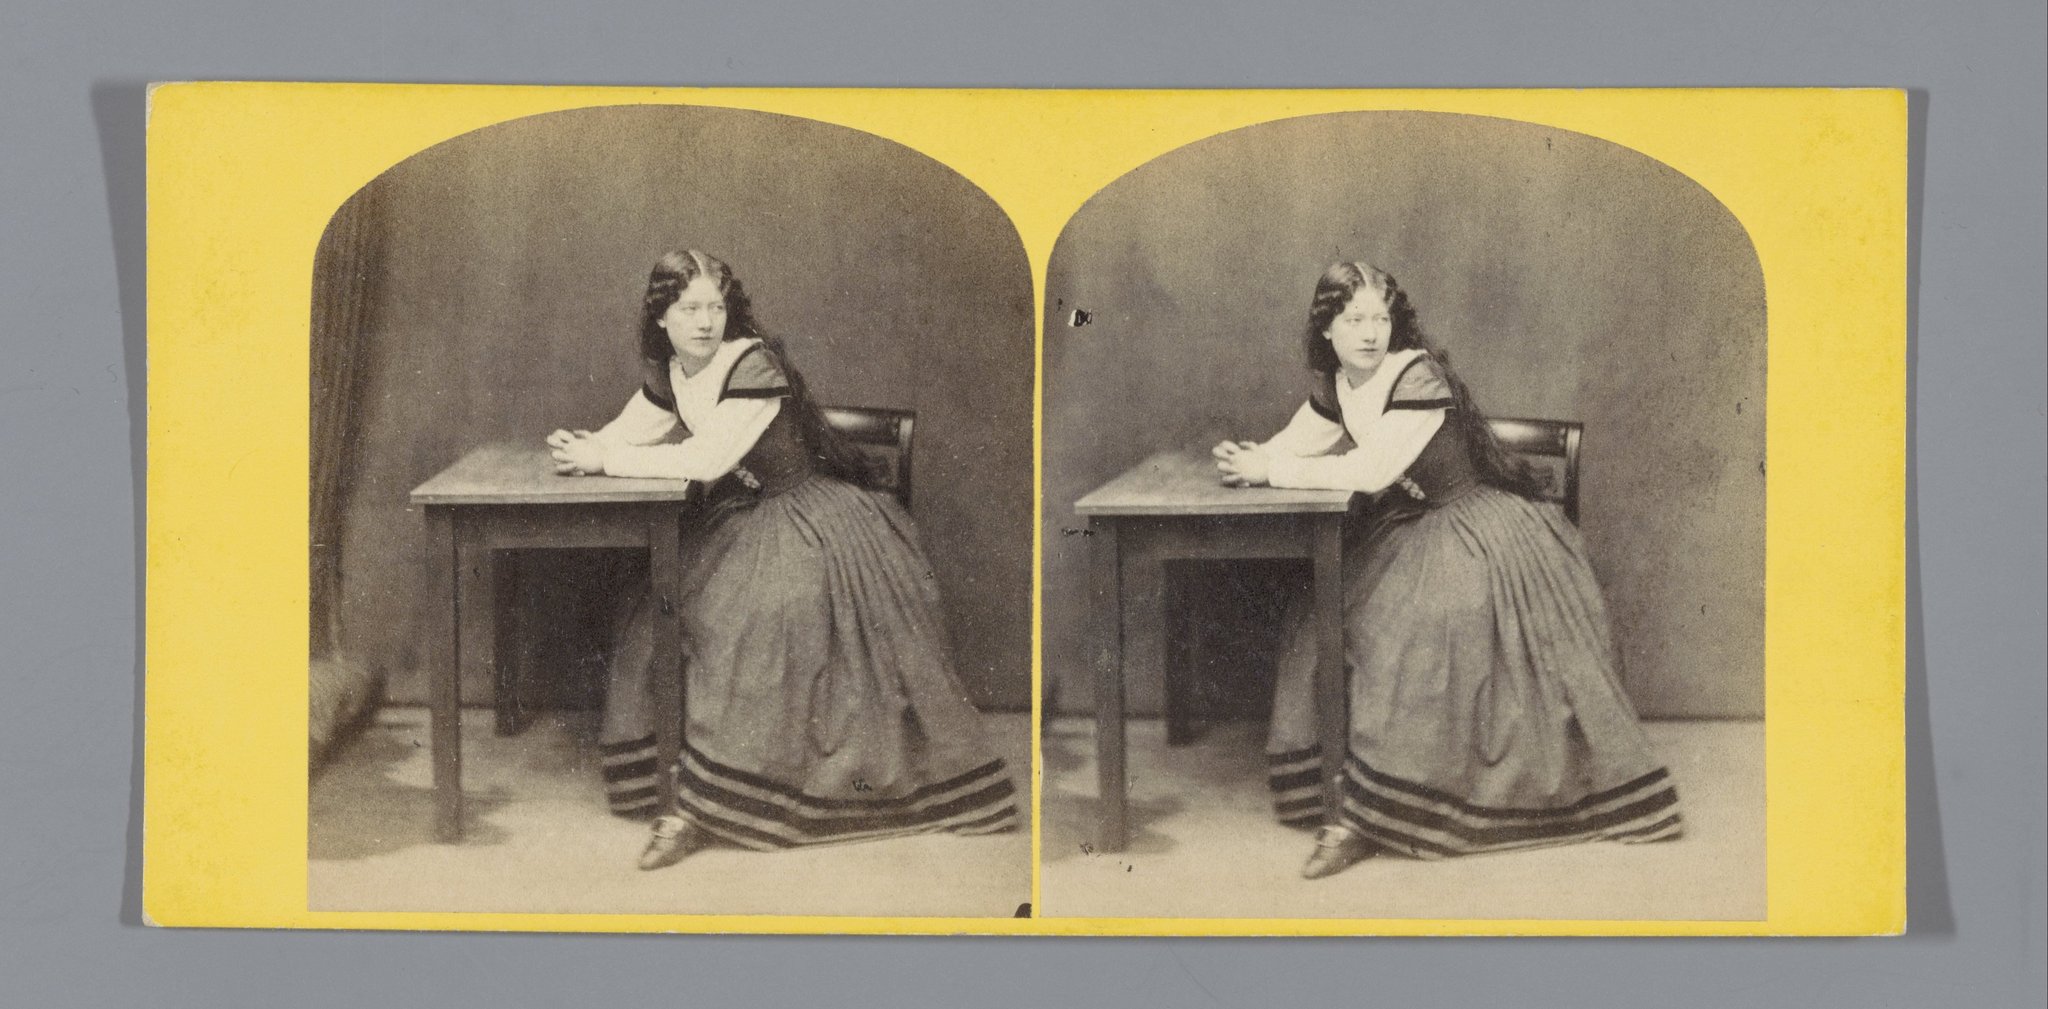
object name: stereograph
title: Kate Terry aan een tafel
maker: Anonymous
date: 1850-1880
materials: cardboard, photographic support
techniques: albumen print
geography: europe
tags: historical persons - bb - woman, europe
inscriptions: inscription: ‘Miss Kate Terry’